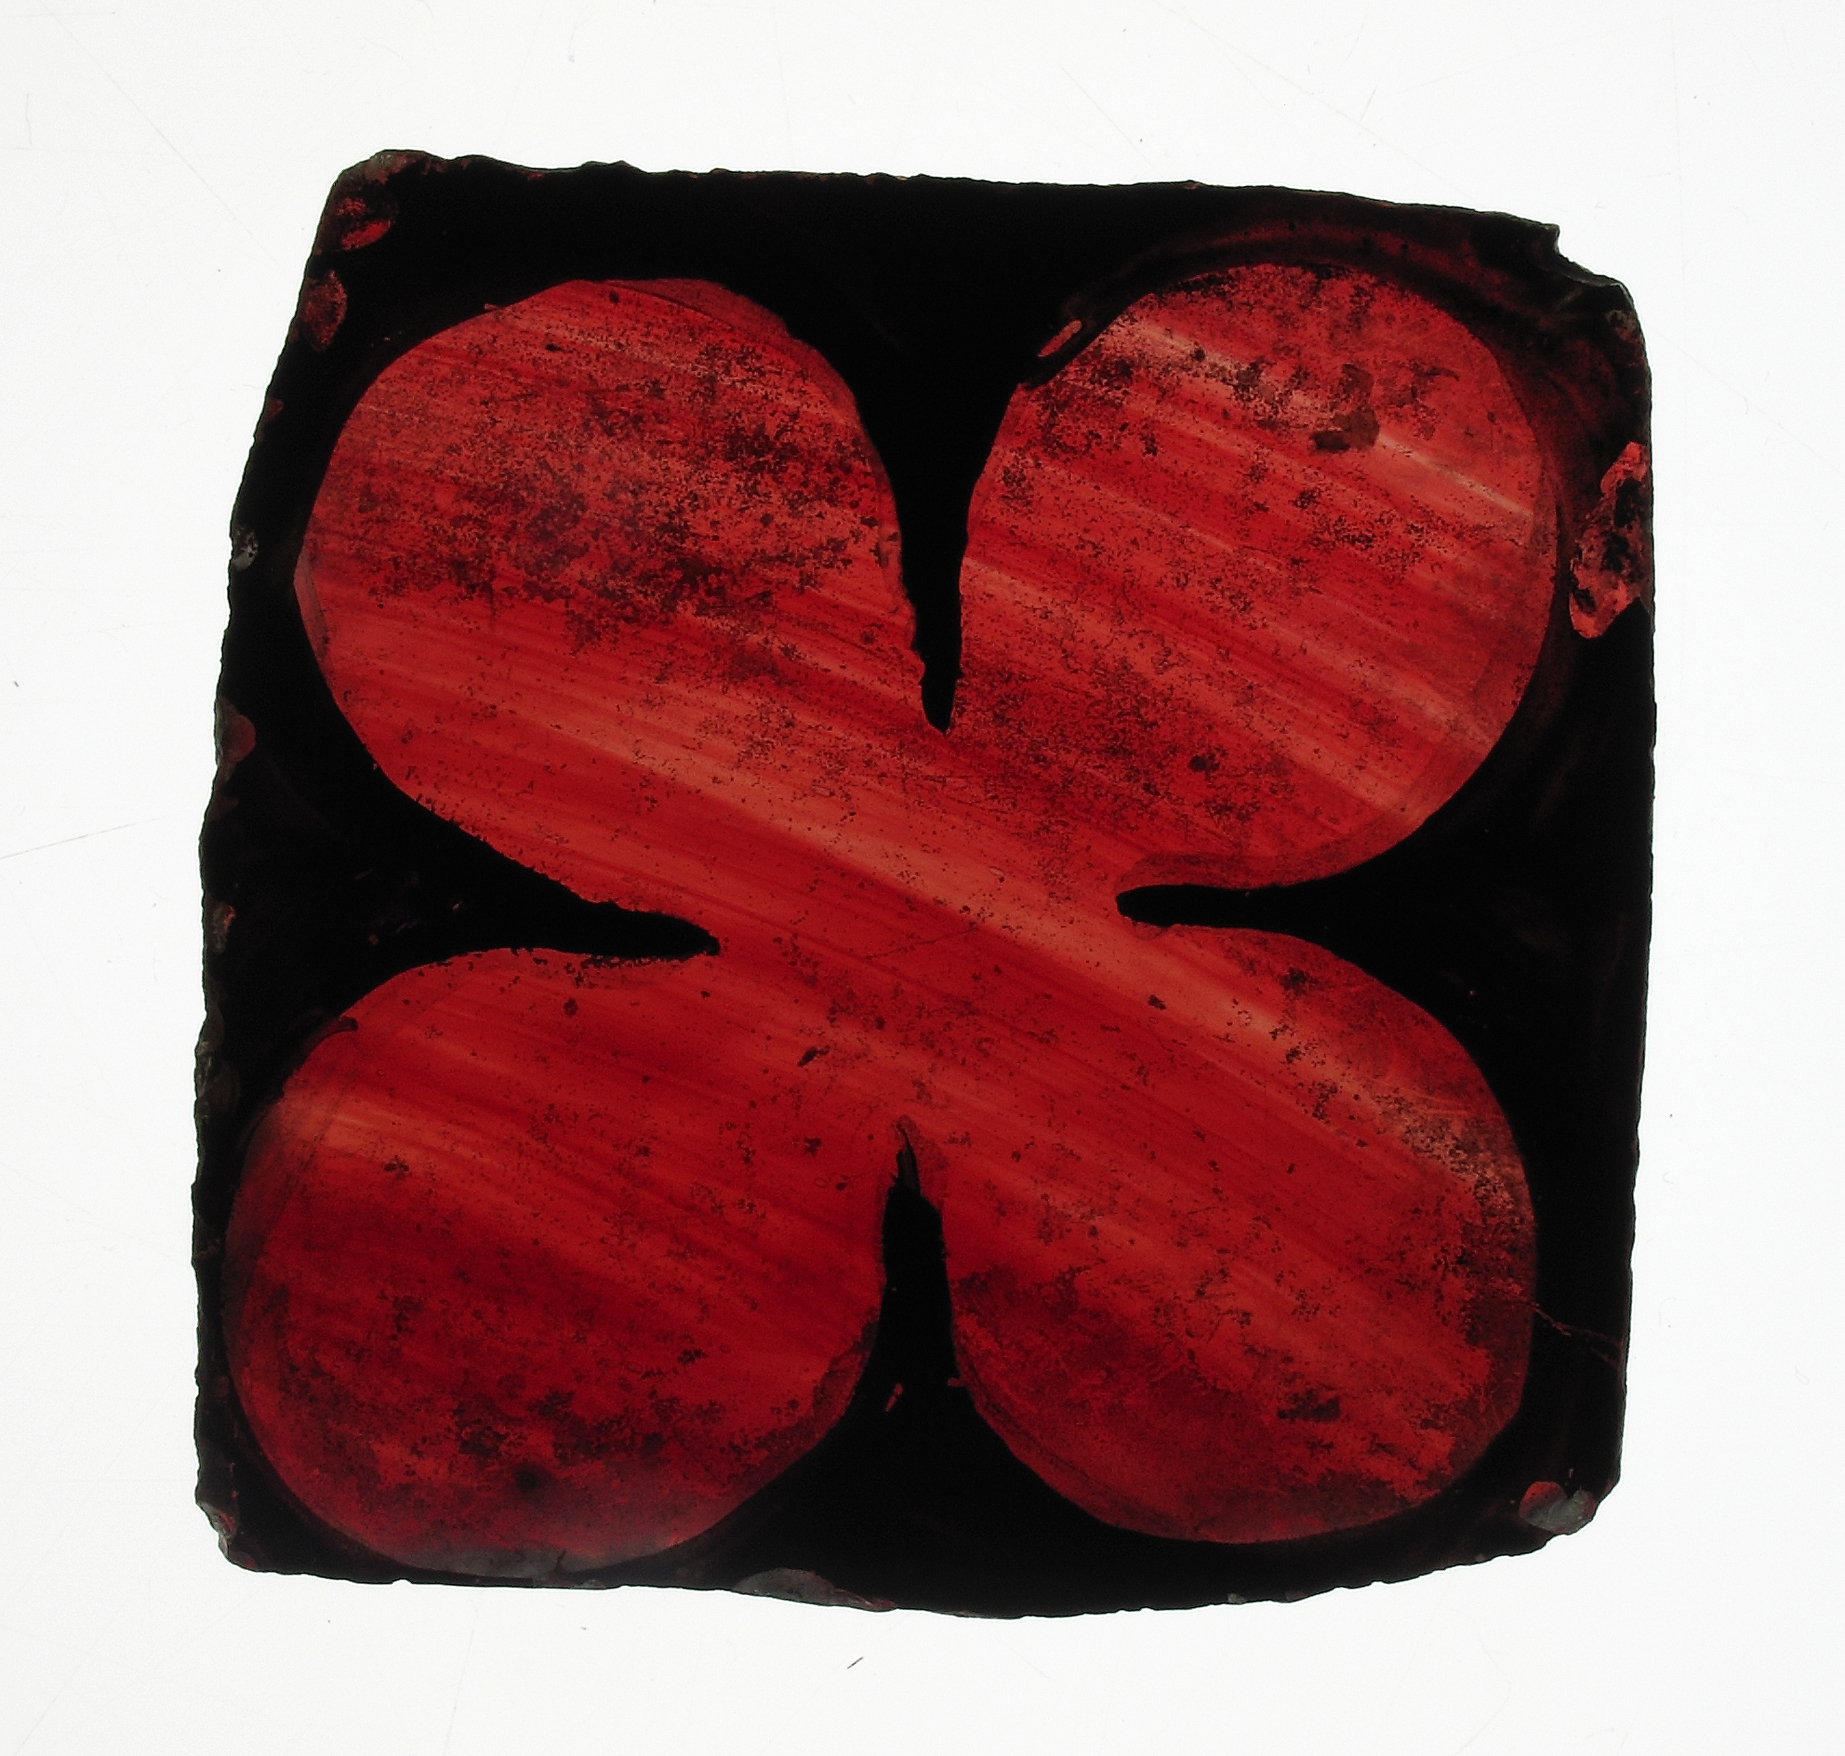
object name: fragment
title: Glass Fragment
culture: european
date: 1301-1400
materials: glass, metal